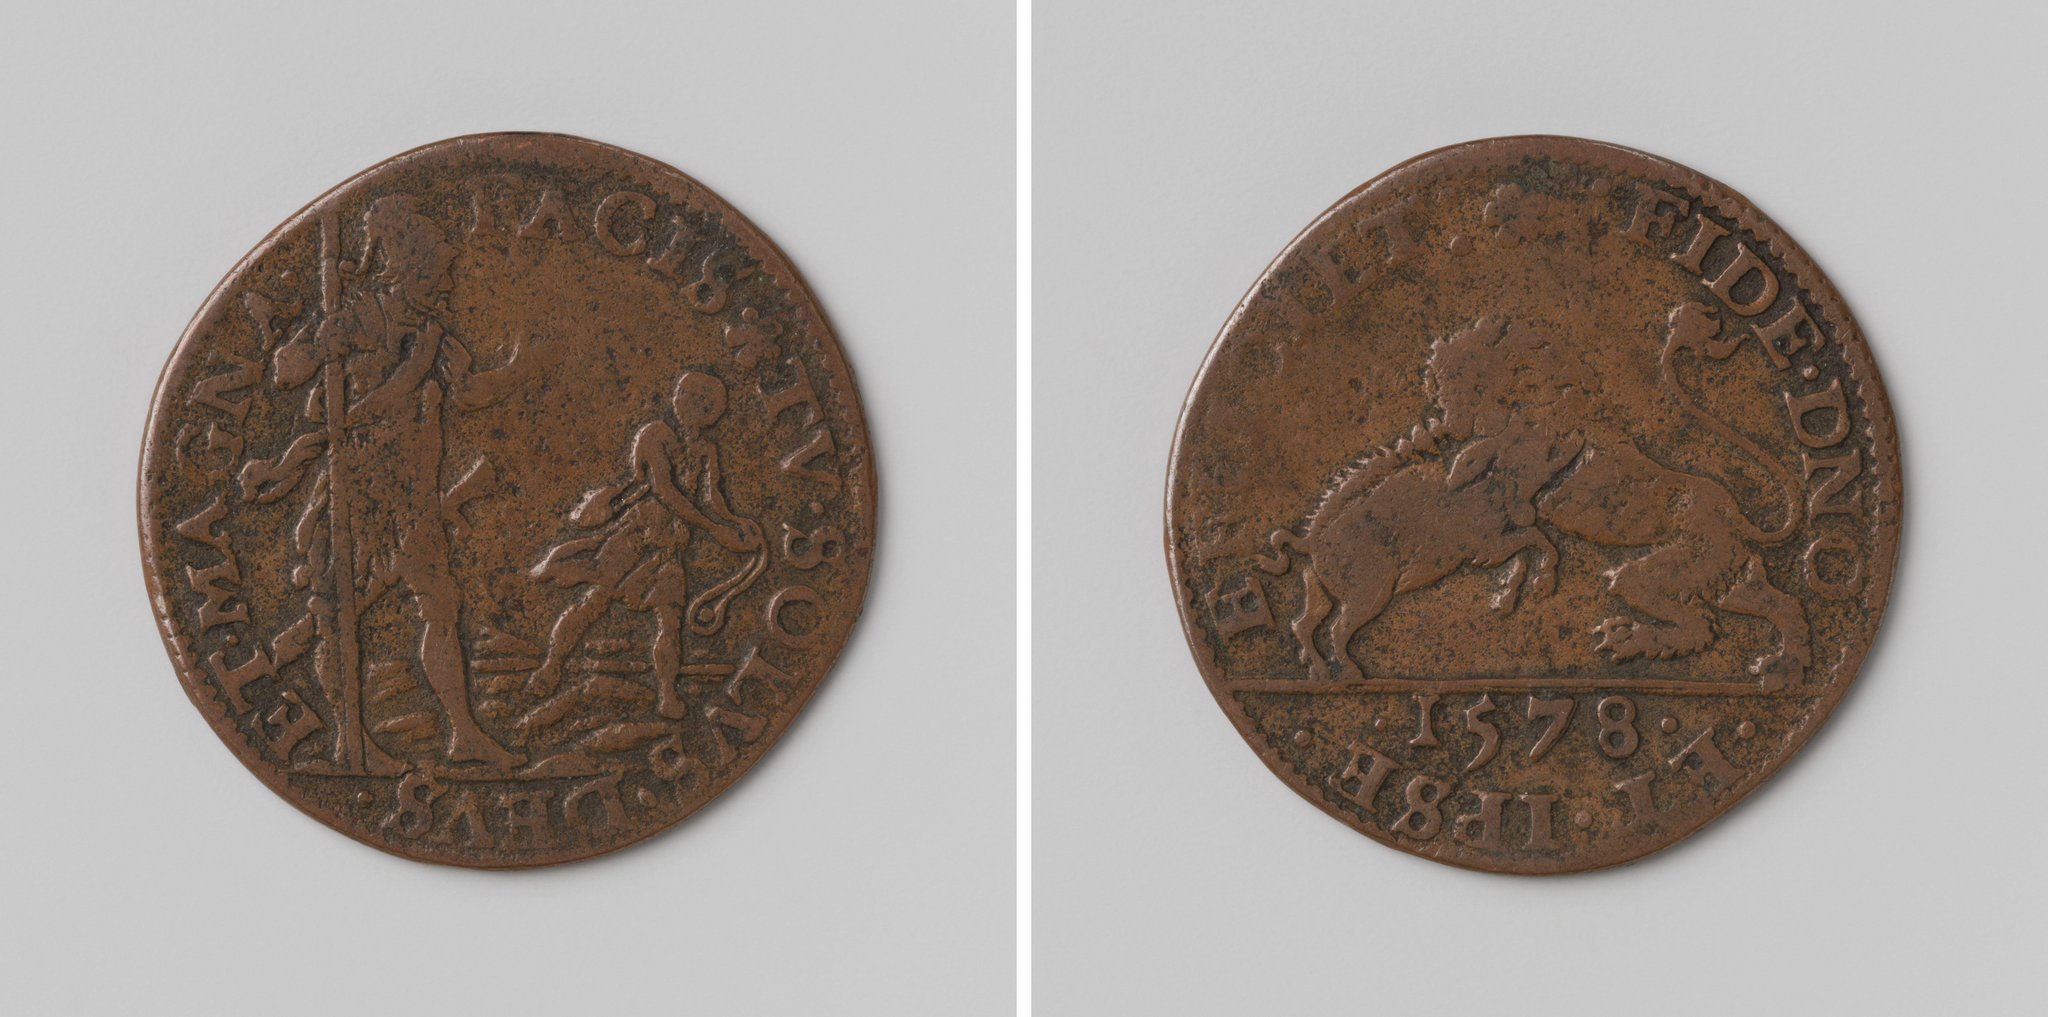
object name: jeton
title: Succes in de strijd tegen Spanje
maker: Anonymous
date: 1578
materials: copper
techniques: striking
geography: dordrecht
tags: tachtigjarige oorlog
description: Koperen penning. Voorzijde: Goliath met speer in volle wapenrusting en David met zijn slinger binnen omschrift. Keerzijde: Nederlandse leeuw bespringt Spaans everzwijn boven jaartal binnen omschrift